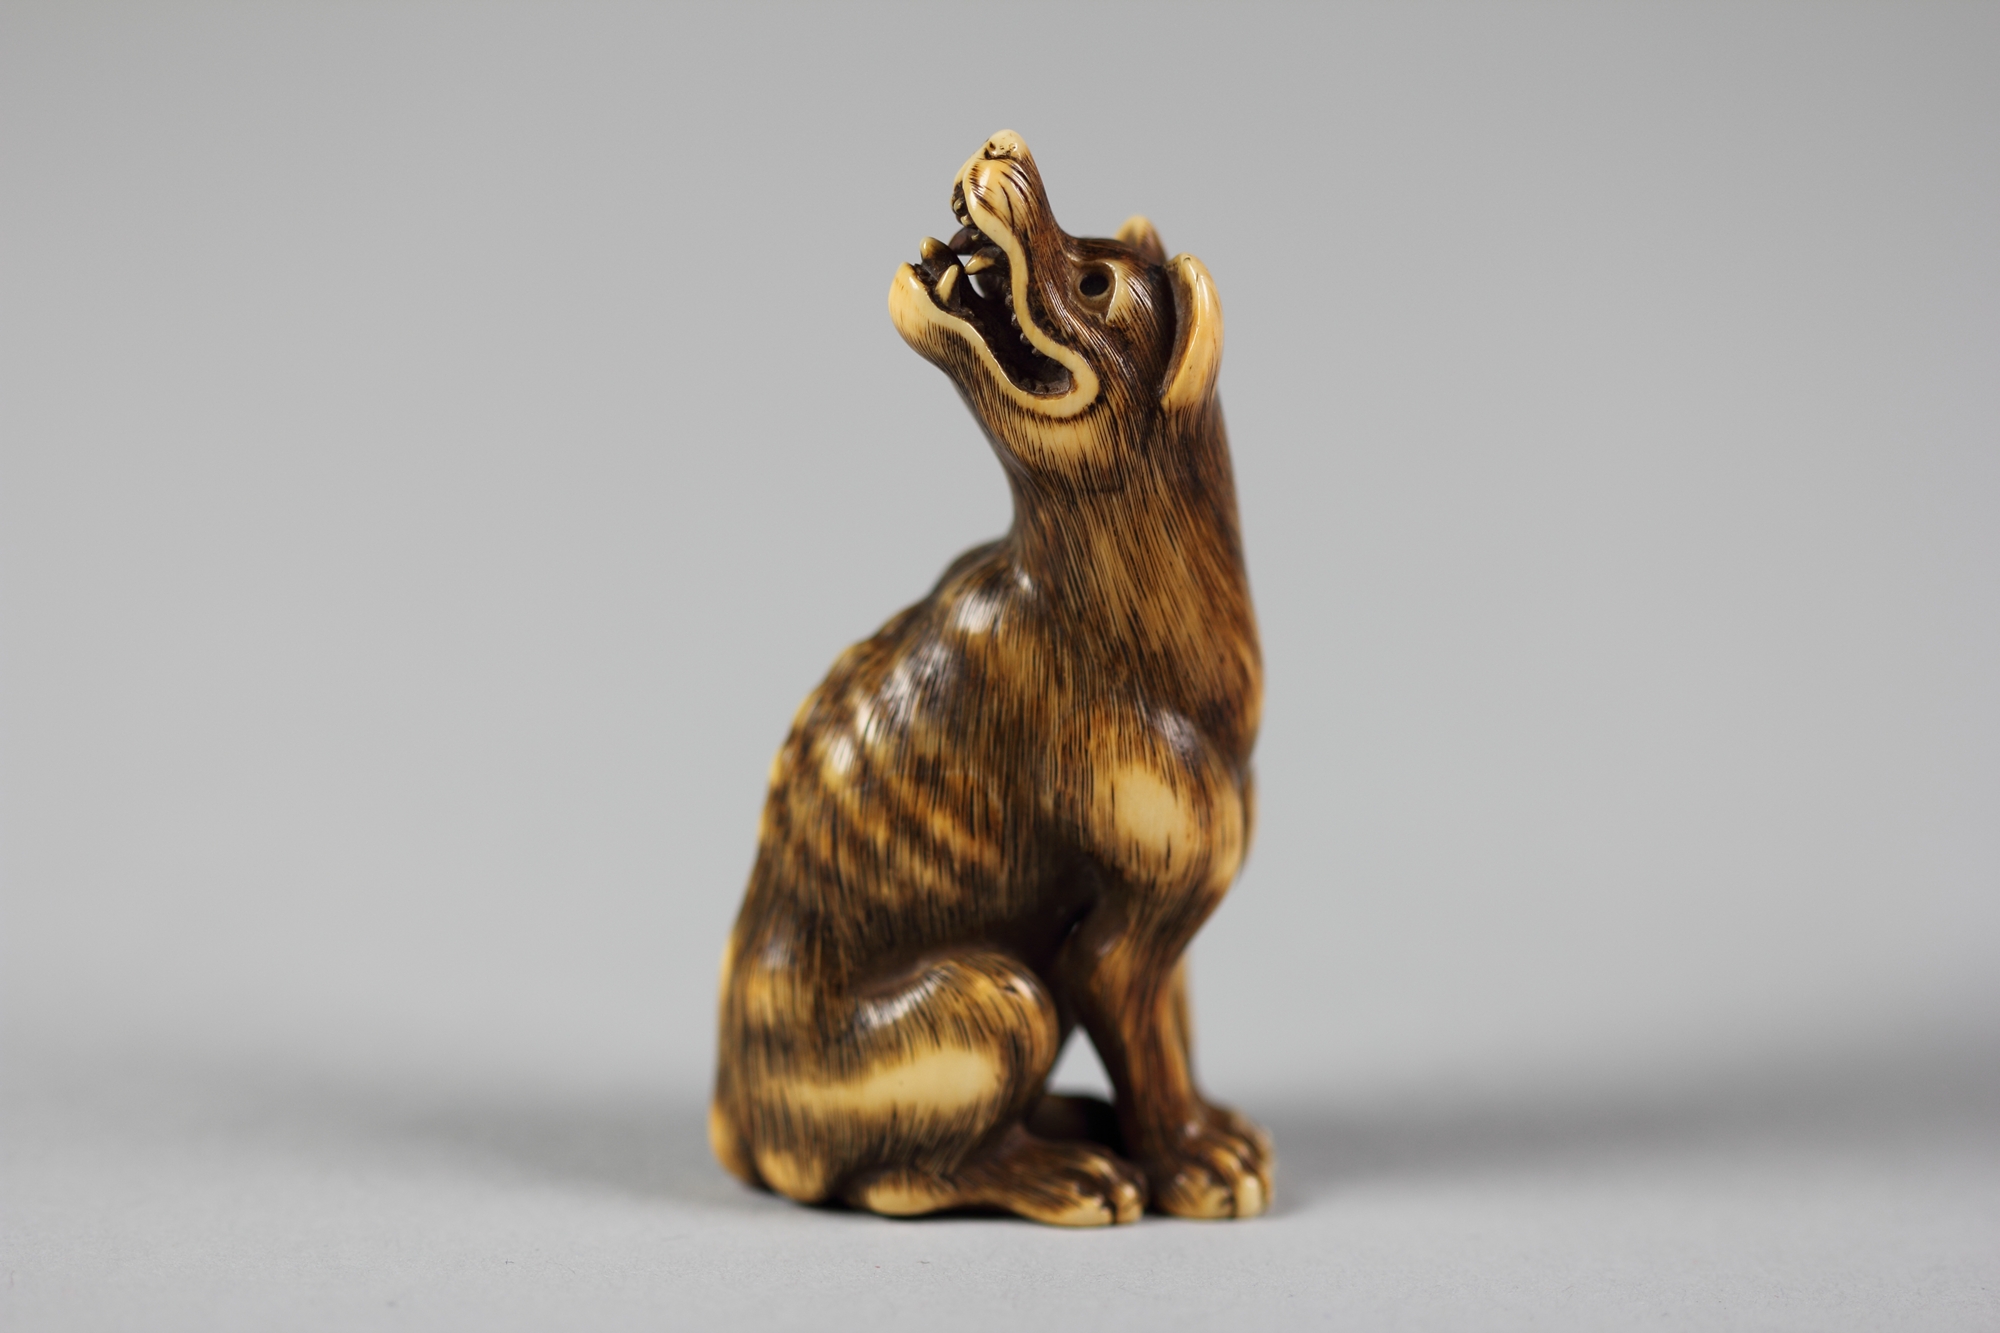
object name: netsuke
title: Dog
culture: japanese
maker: tomotada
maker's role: artist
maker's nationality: japanese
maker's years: 1777-1833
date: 1767-1833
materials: ivory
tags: dogs